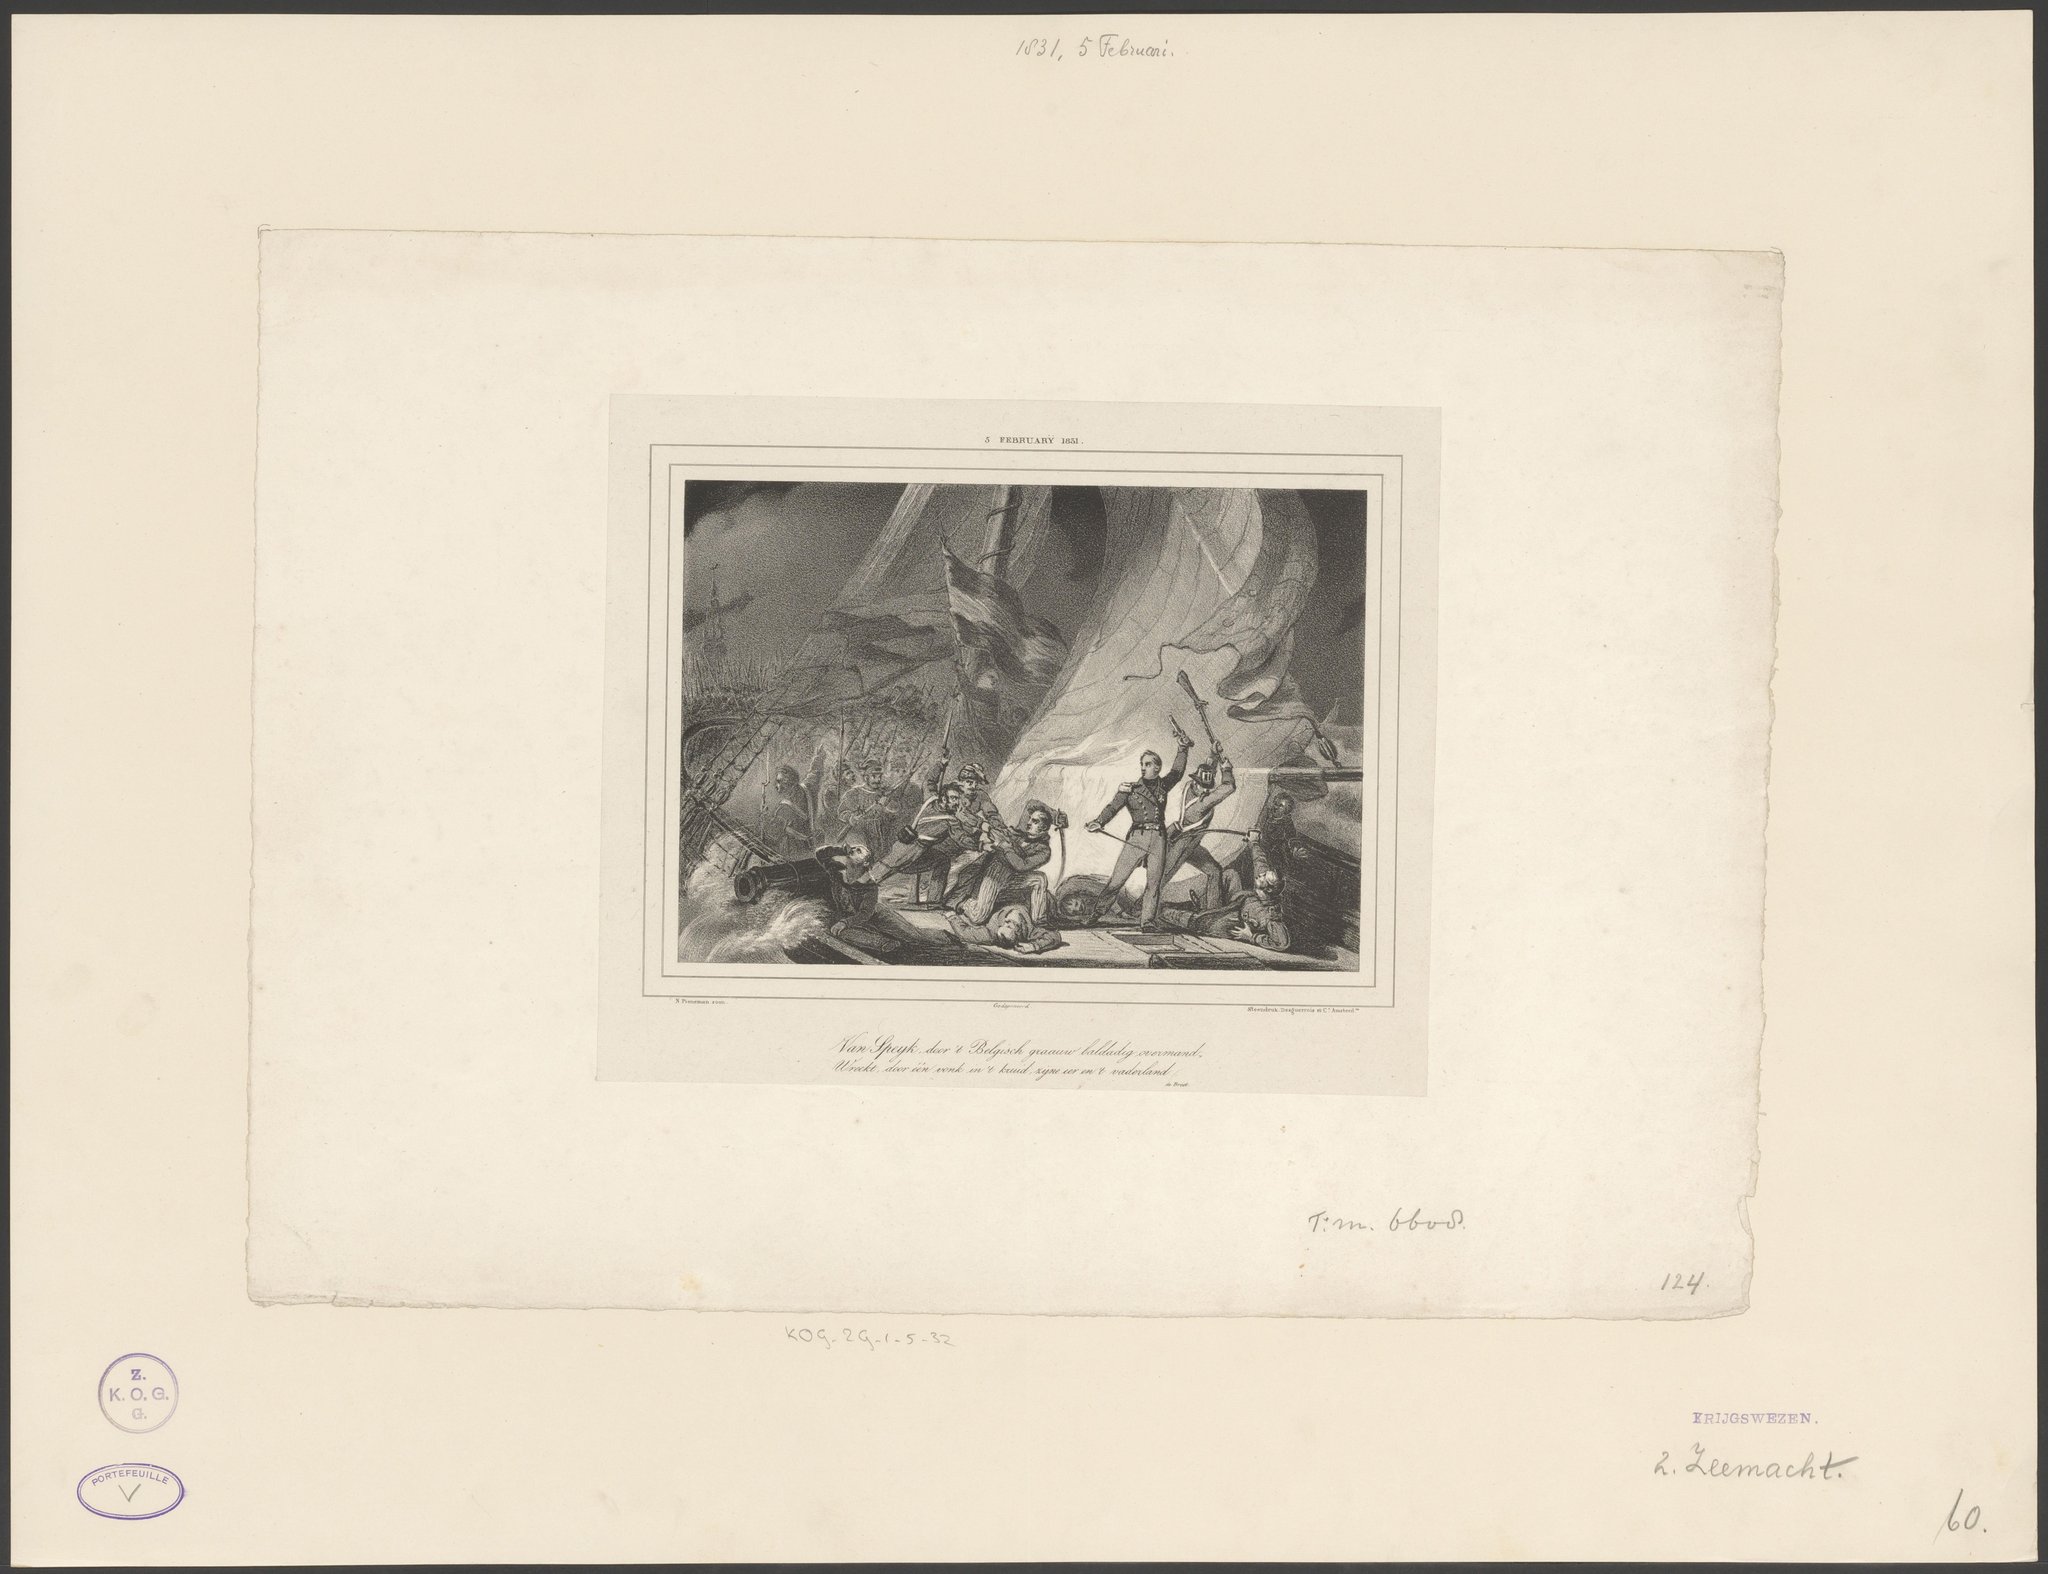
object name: print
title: Kanonneerboot twee van Jan van Speyk overrompeld, 1831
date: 1831-1849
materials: paper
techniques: lithograph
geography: amsterdam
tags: amsterdam, antwerp, jan van speyk, battle, fighting in general (+ naval force), ships (in general) - cc - more than one ship, being attacked; defence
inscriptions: collector's mark: Lugt 1641, stamp, stamp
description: De kanonneerboot van Jan van Speyk overrompeld door Belgische opstandelingen. Jan van Speyk staat met pistool in opgeheven hand bij de kajuitstrap, 5 februari 1831. Onderwerpsrubrieken binnen de Atlas Zeden en Gewoonten: Krijgswezen, Zeemacht.